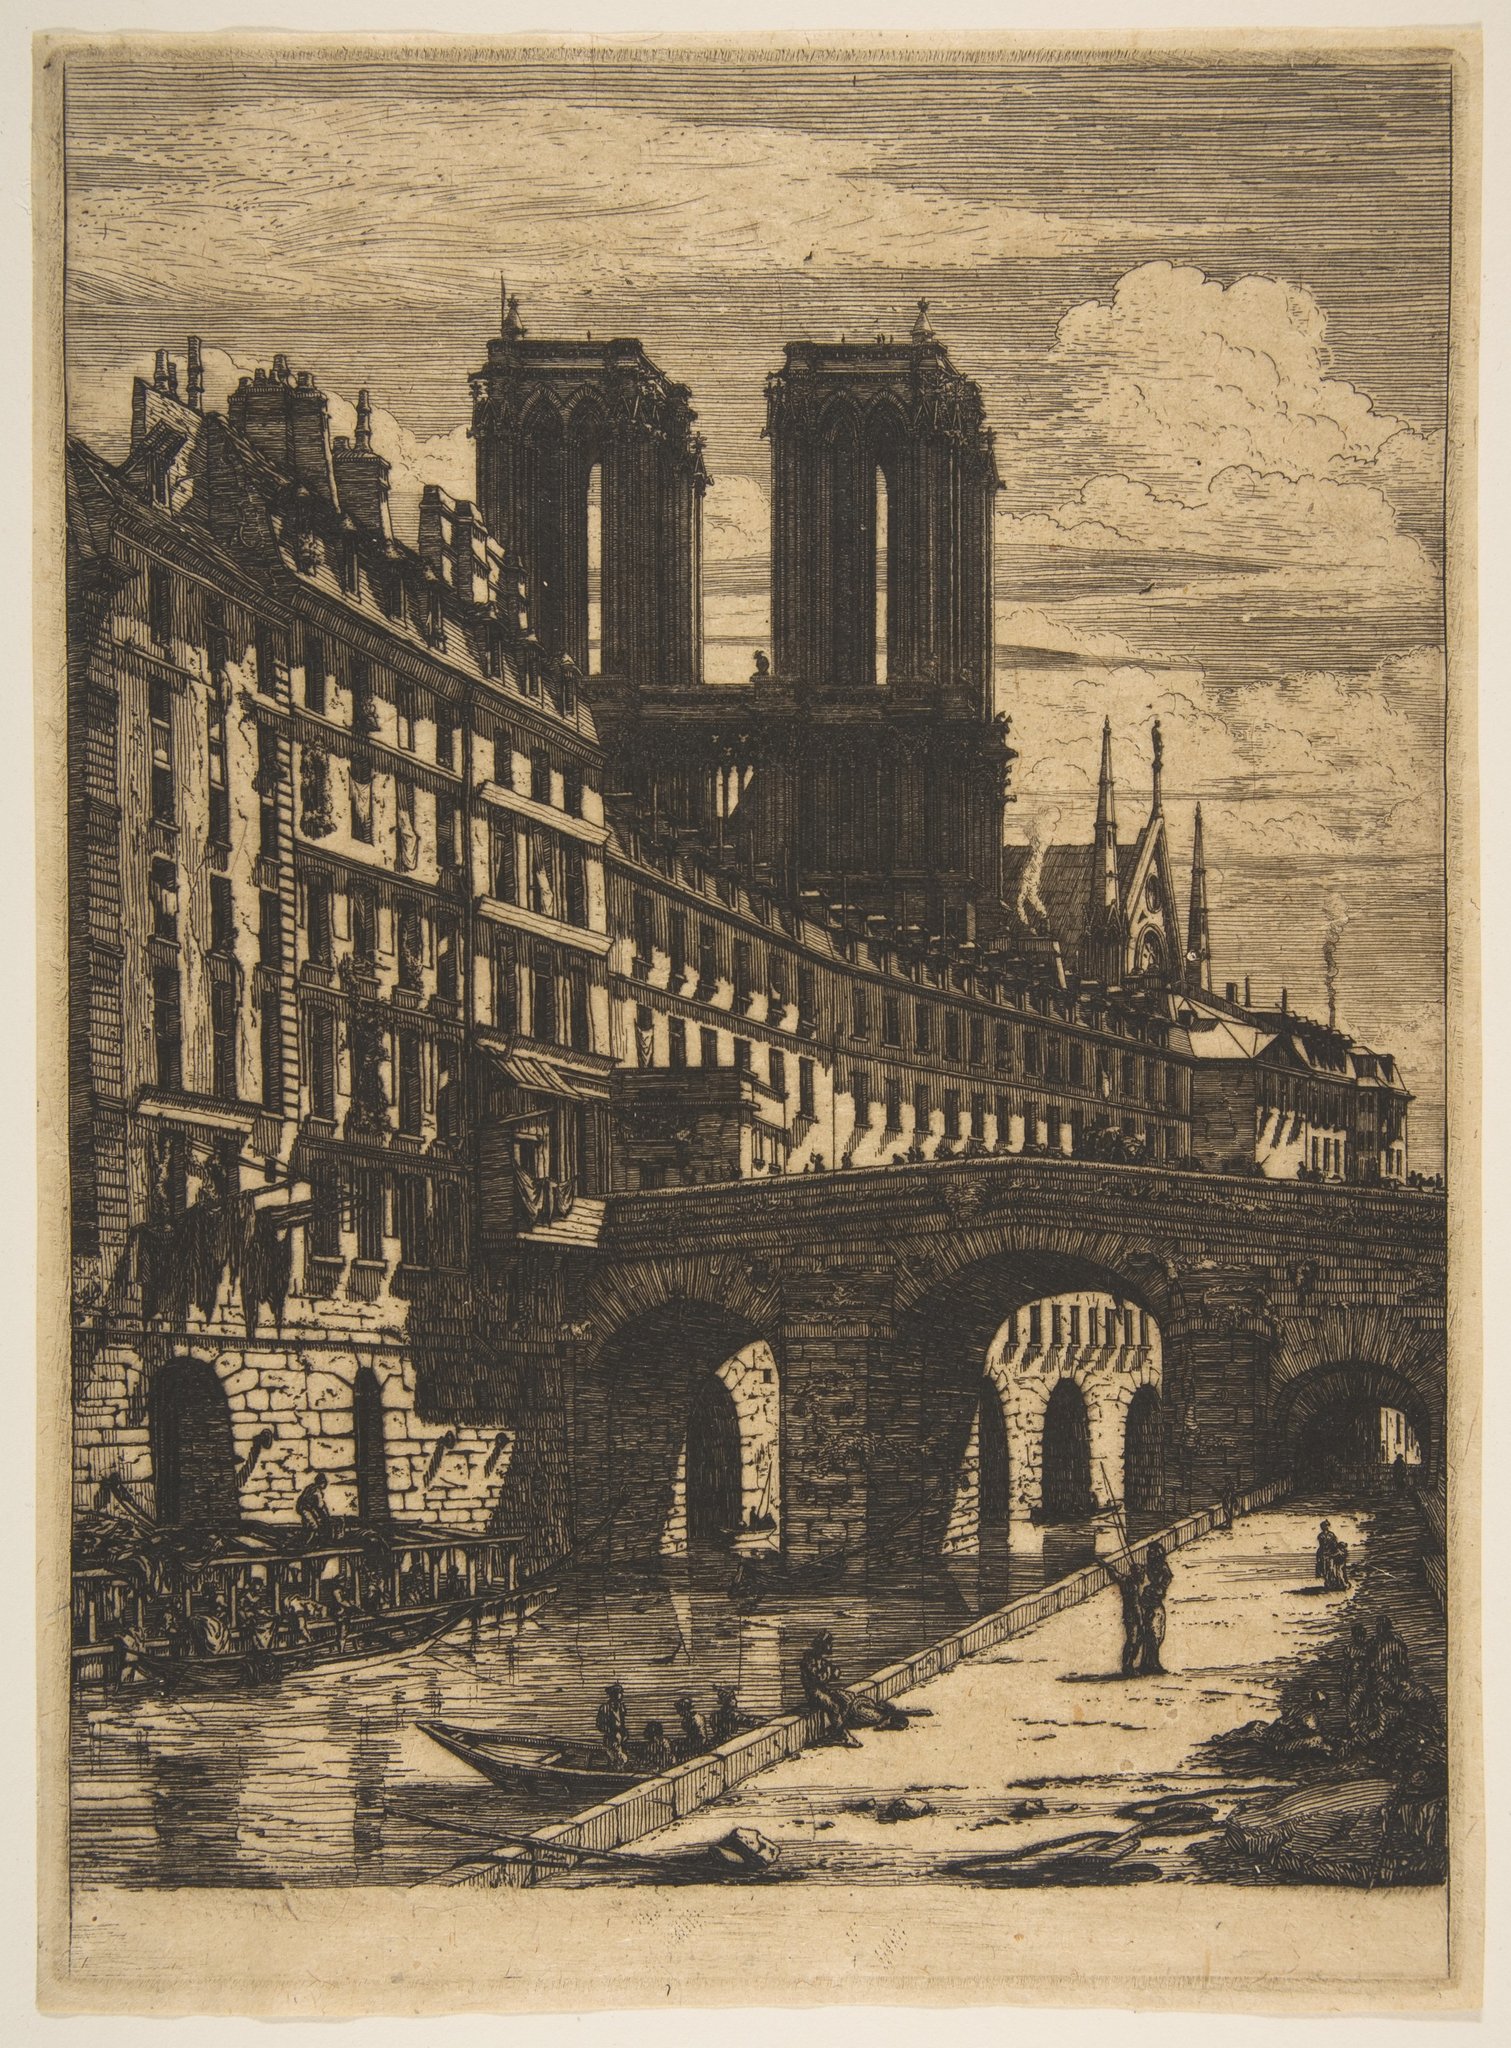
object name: print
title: The Petit Pont, Paris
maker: charles meryon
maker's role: artist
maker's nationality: french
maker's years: 1821-1868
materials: paper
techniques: engraving, etching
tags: buildings,bridges,boats,paris